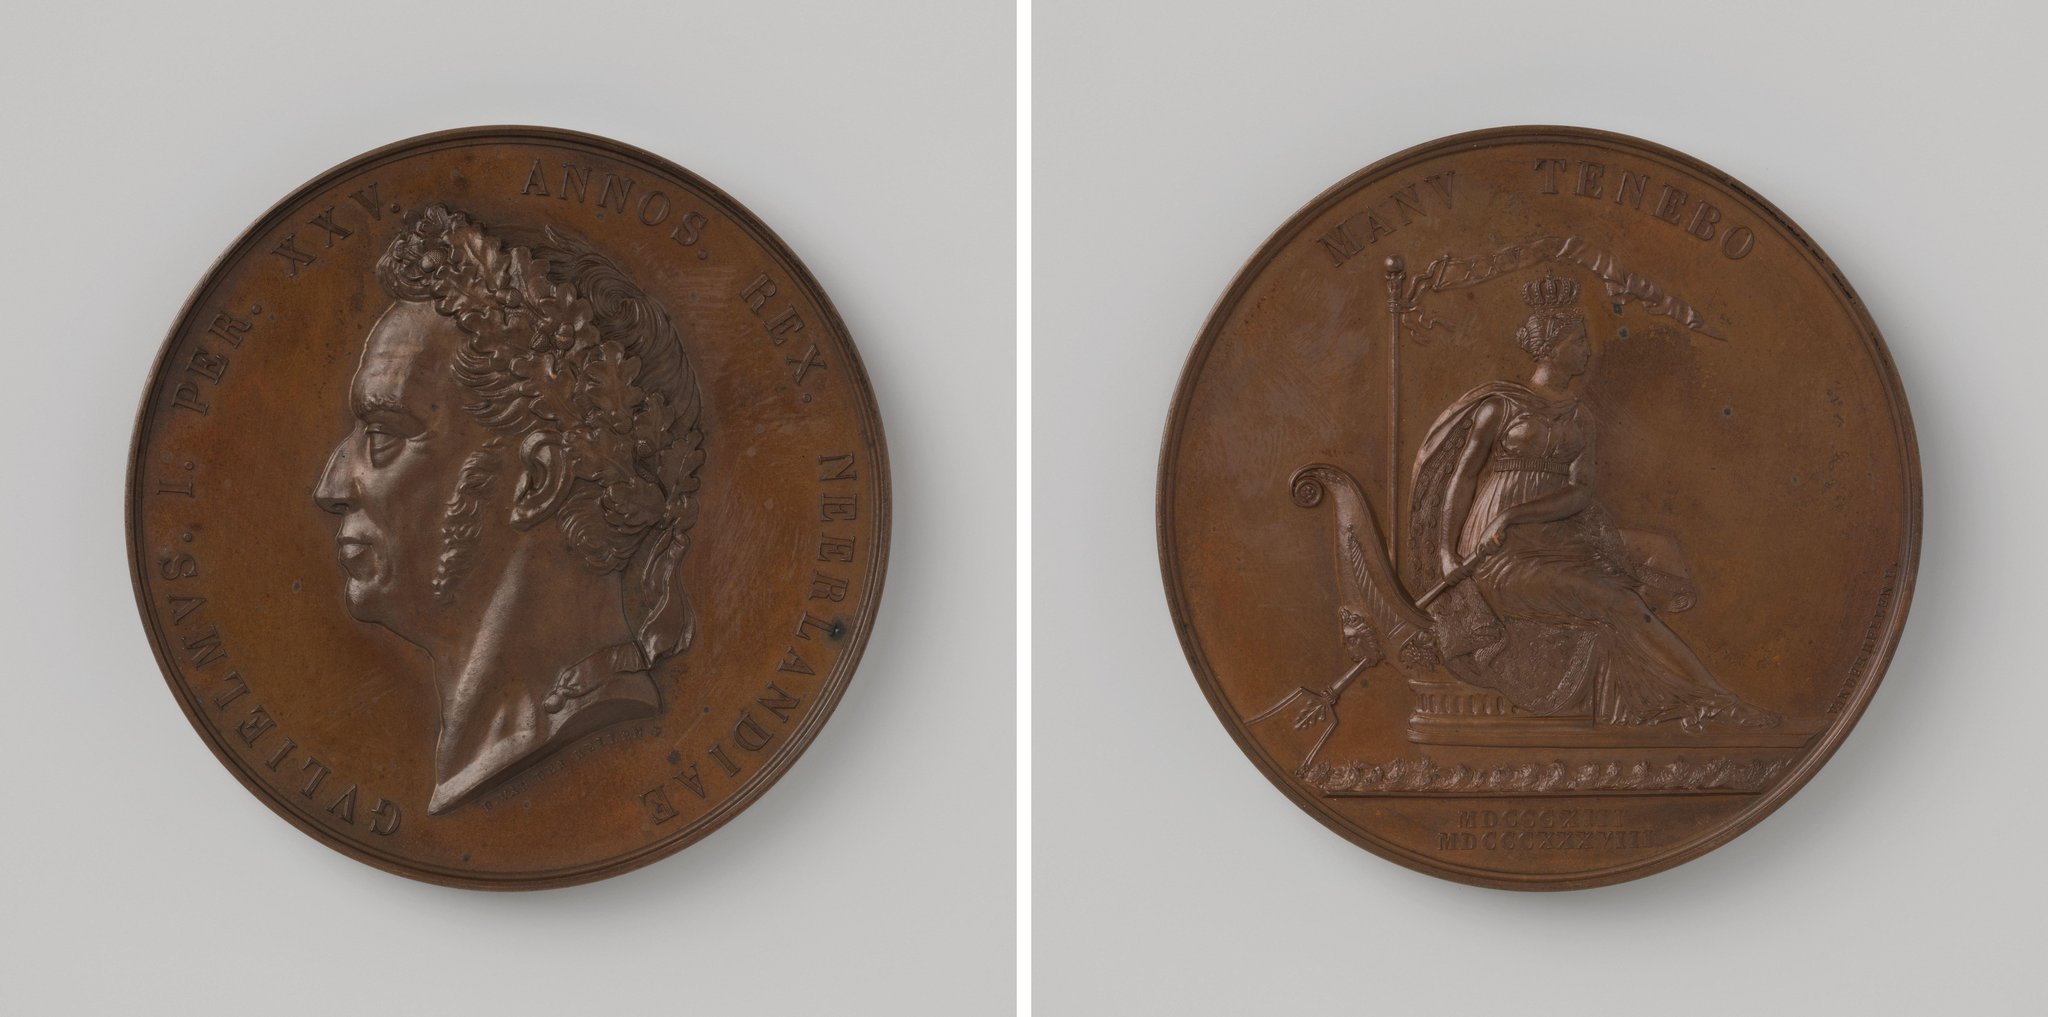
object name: history medal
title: Vijfentwintigjarig regeringsjubileum van Koning Willem I 1838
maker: johannis petrus schouberg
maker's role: die cutter, draughtsman, print maker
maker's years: 1798-1864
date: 1838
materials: bronze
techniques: striking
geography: utrecht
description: Bronzen penning, op de voozijde het portret van Willem I naar links met eikenkrans, met omschrift, op de keerzijde een gekroonde vrouw in hermelijnen mantel aan het roer op de achterplecht van een naar rechts varende boot, naast een vlaggenstok met wimpel, met omschrift en afsnedetekst.